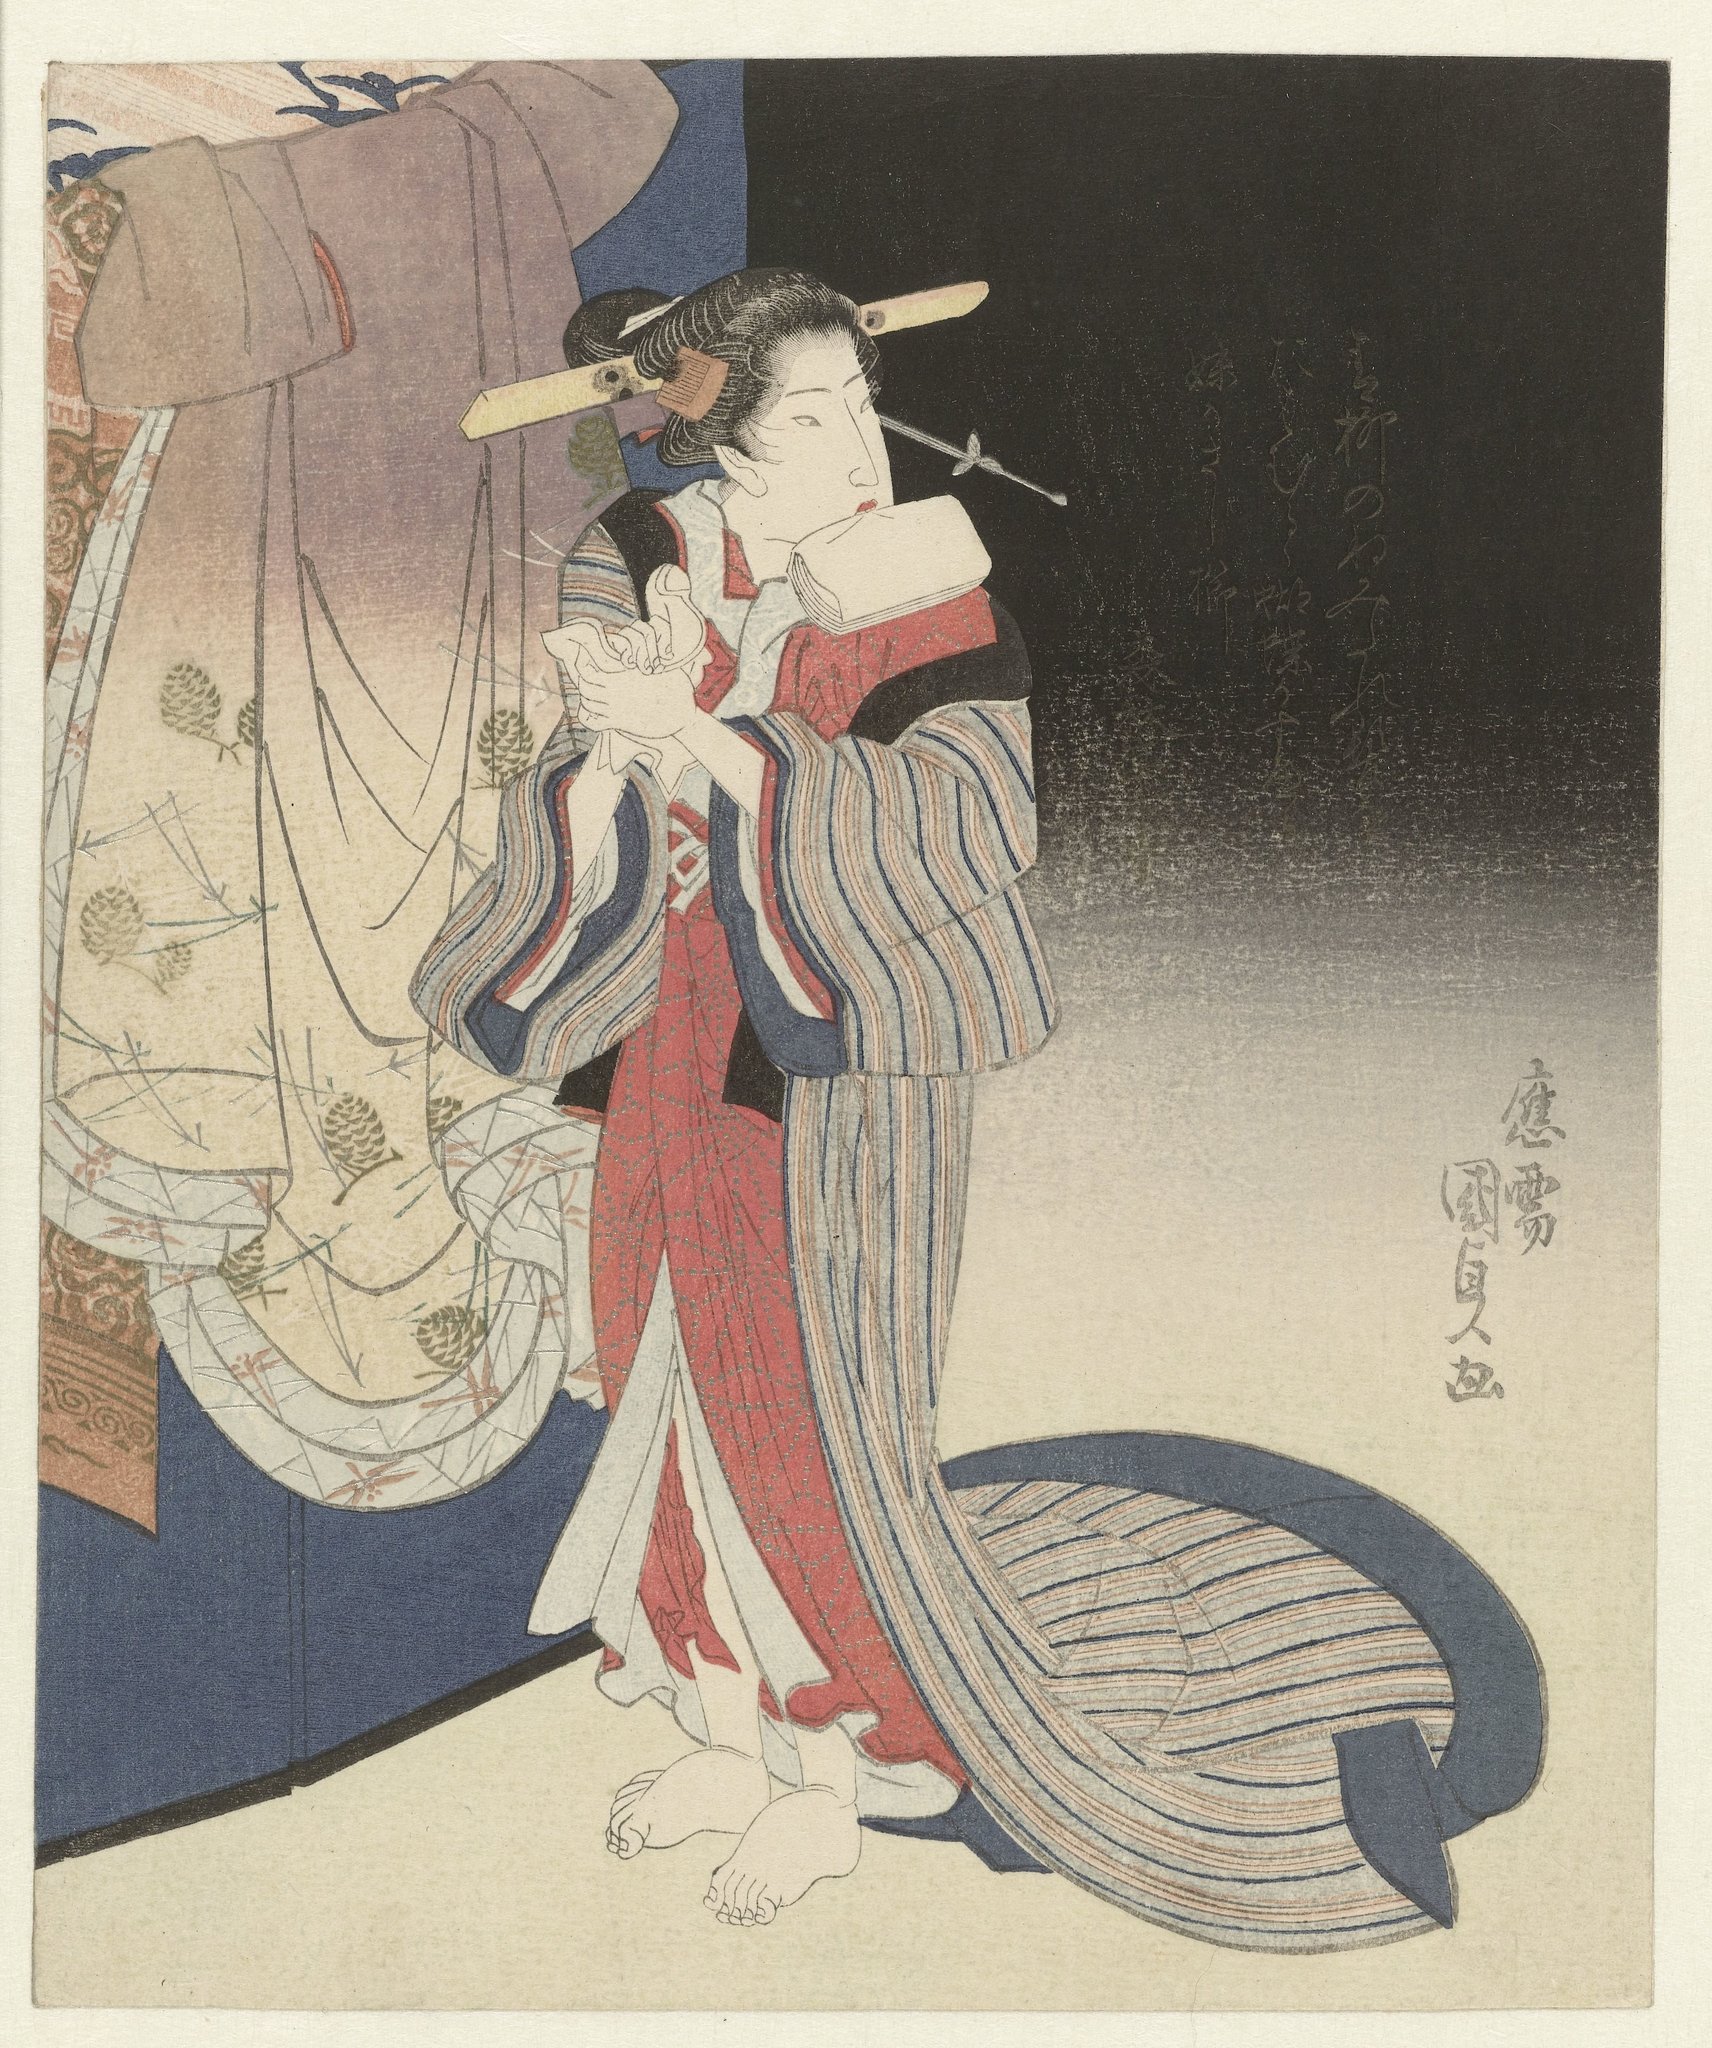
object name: surimono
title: Courtisane bereidt zich voor op de nacht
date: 1826-1827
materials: paper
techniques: blind stamped, woodcut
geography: japan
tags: courtesan, hetaera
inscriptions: collector's mark, verso, stamped: Lugt 2228, collector's mark, passe-partout, bottom left, printed: JABdH with a rooster.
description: Een surimono is een luxe uitgevoerde prent waarop beeld met één of meerdere gedichten gecombineerd is. Bij het drukken van een surimono werd vaak gebruik gemaakt van dikker papier, blinddruk en metaal pigmenten, zoals koper- en zilverpoeder. De prenten werden vaak in opdracht van dichters gemaakt en als exclusief geschenk aan vrienden en relaties gegeven.